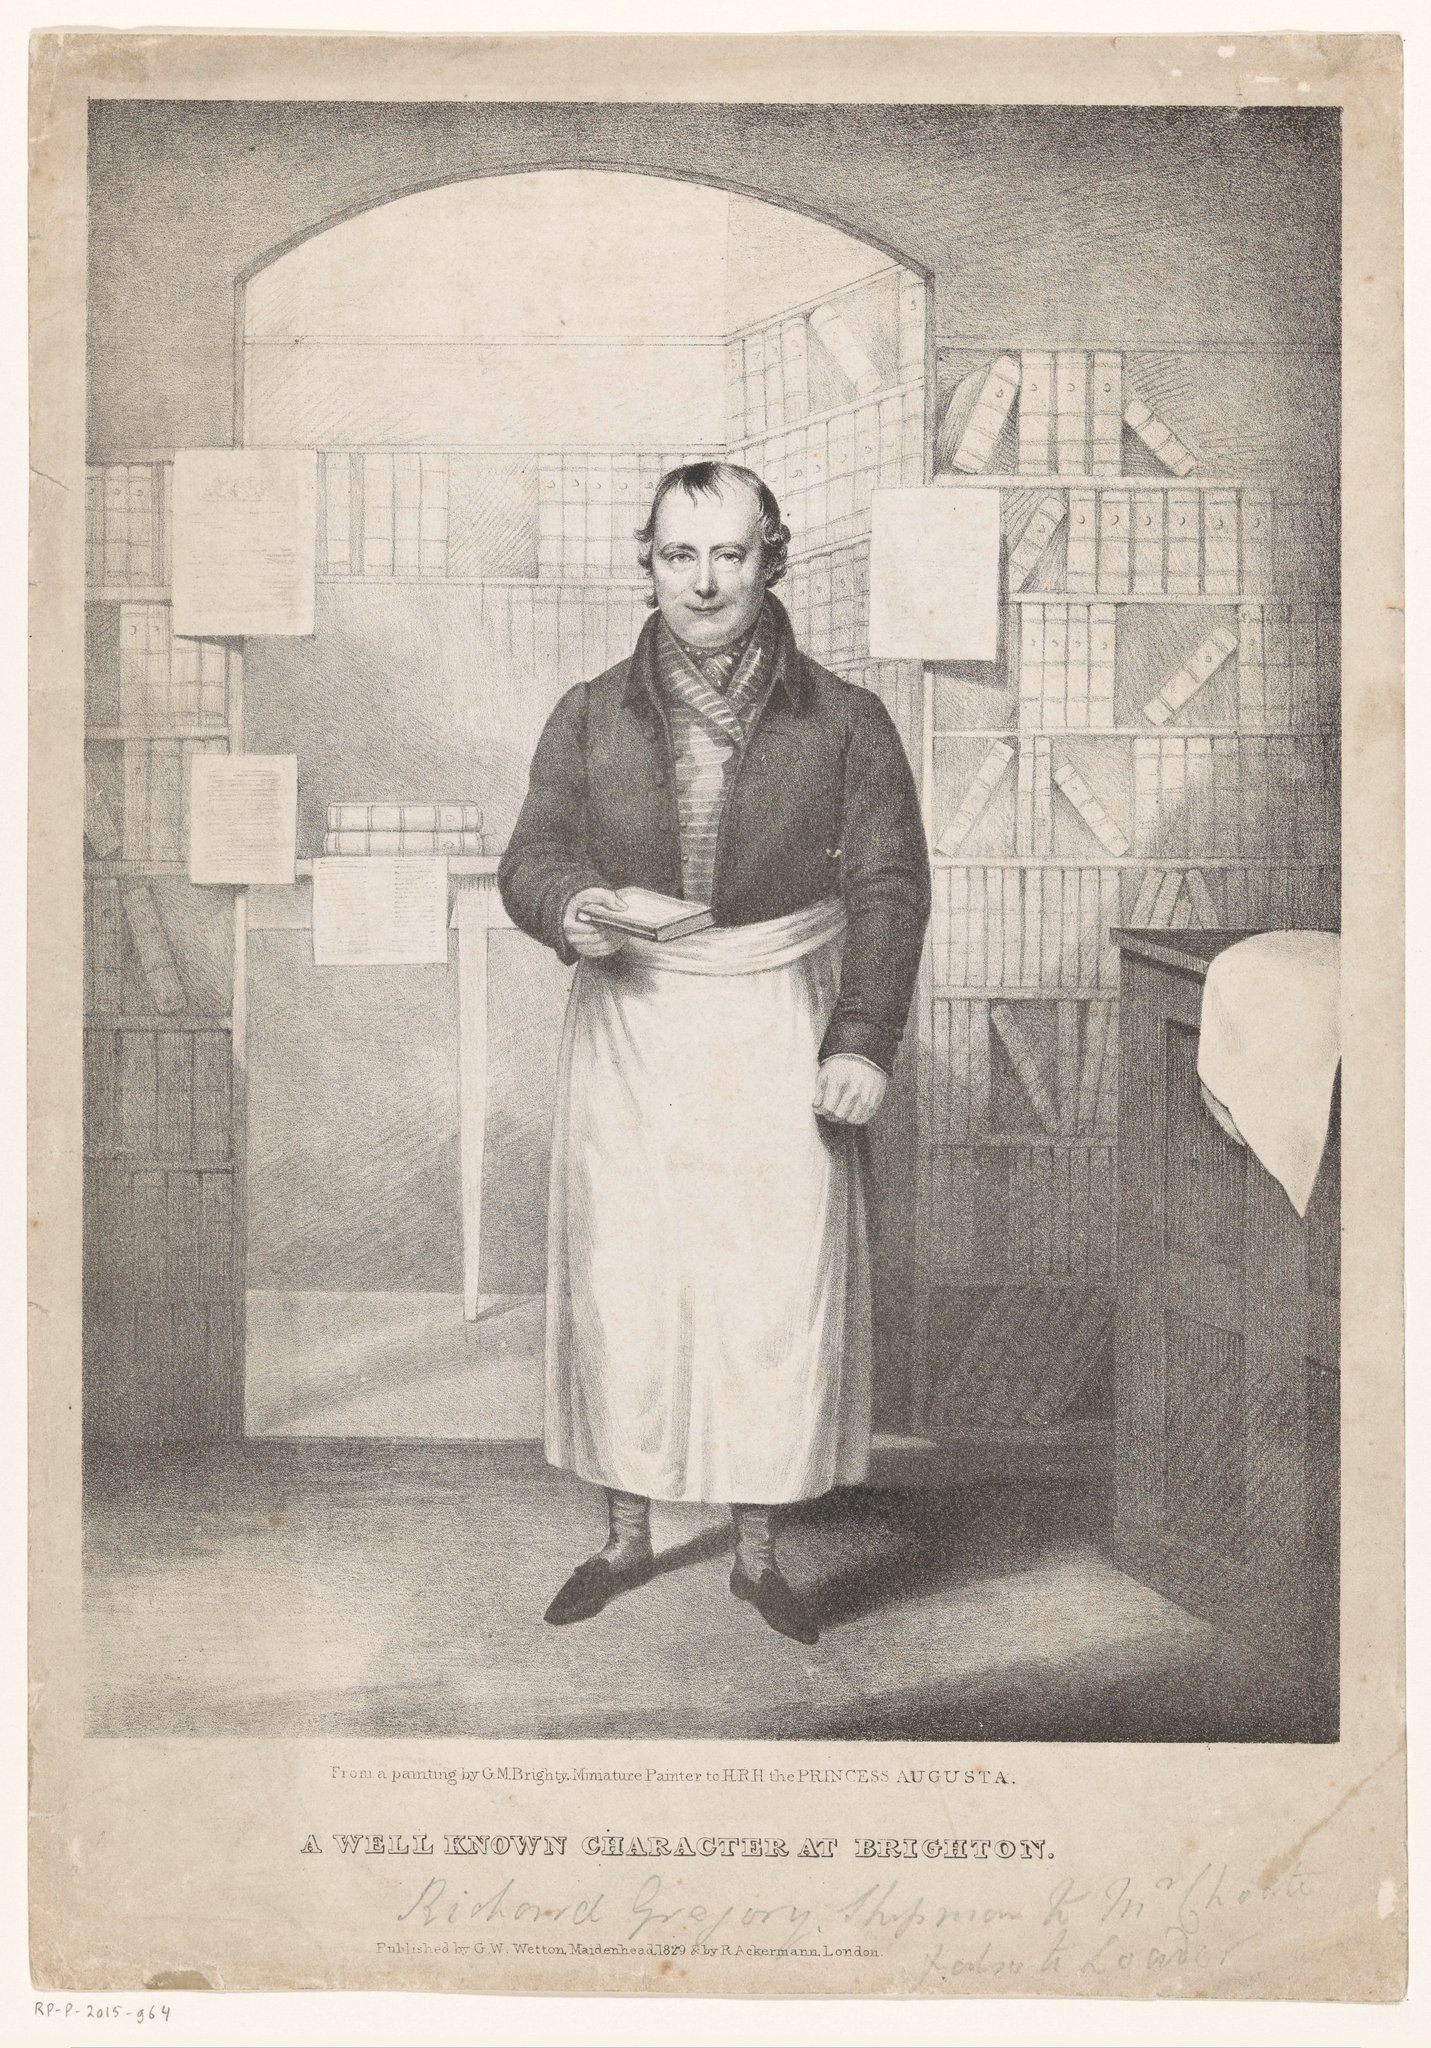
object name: print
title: A well known character at Brighton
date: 1829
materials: paper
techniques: lithograph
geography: maidenhead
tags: public library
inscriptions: collector's mark: Lugt 4779, annotation: ‘Richard Gregory shopman at mr. Choate later [?] at Loader’, collector's mark: Lugt 2228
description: Richard Lemmon Gregory werkte als bibliothecaris onder andere voor Loder's Library en Choat's Library in Brighton.